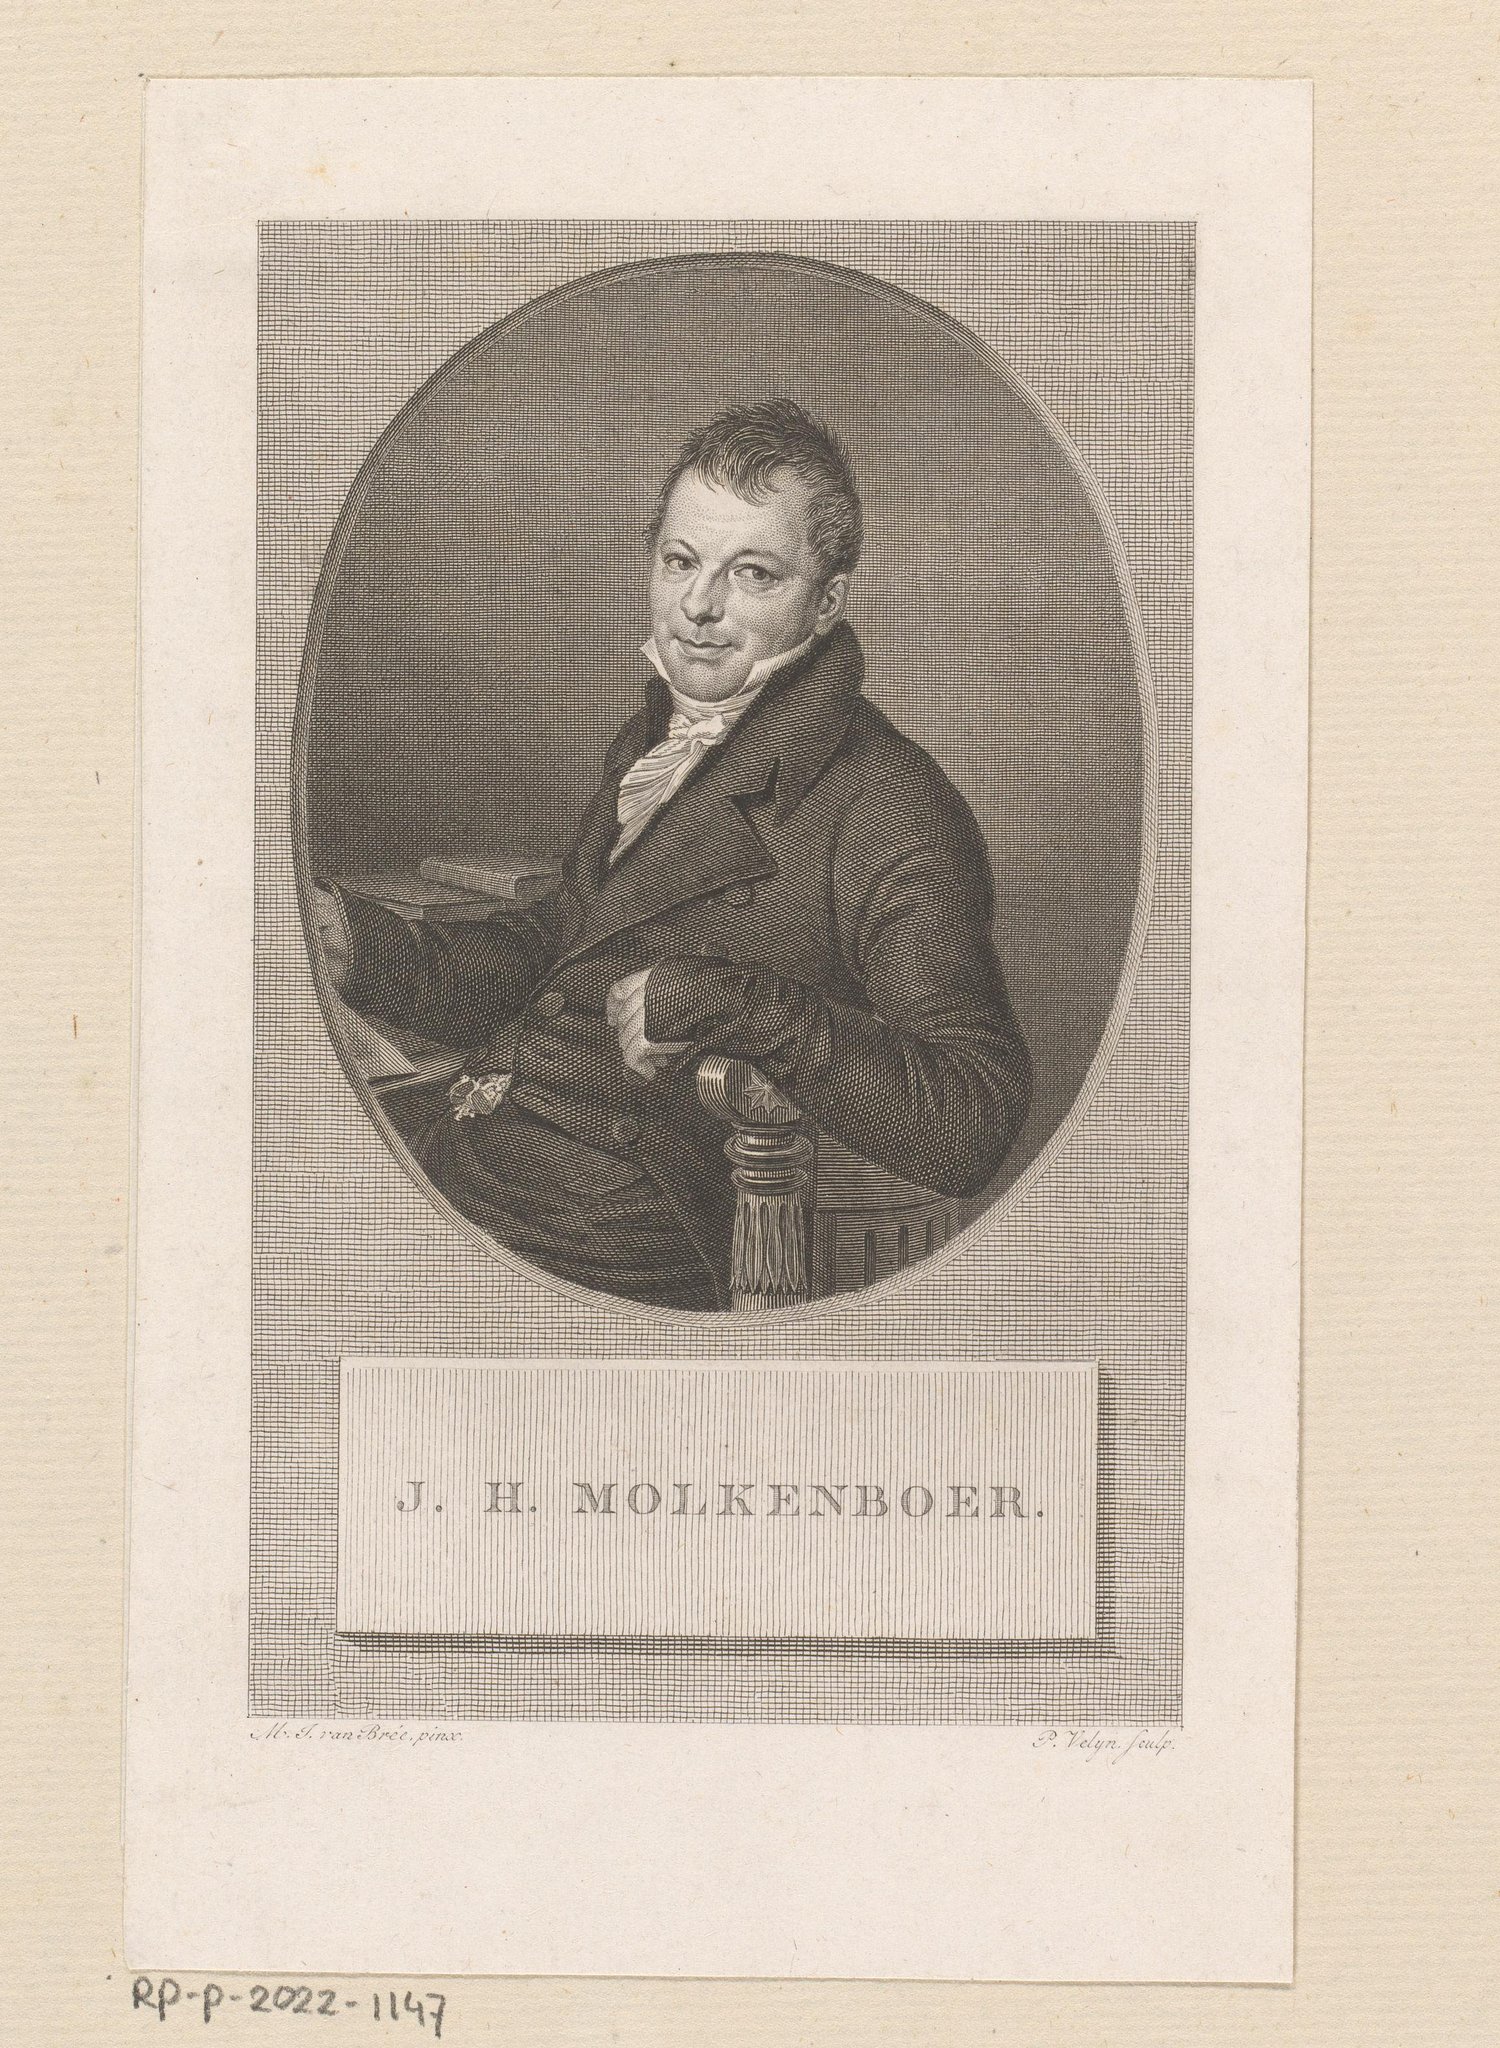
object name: print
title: J.H. Molkenboer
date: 1797-1836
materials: paper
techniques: engraving, etching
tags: amsterdam, johannes hermannus molkenboer, historical persons, art collector